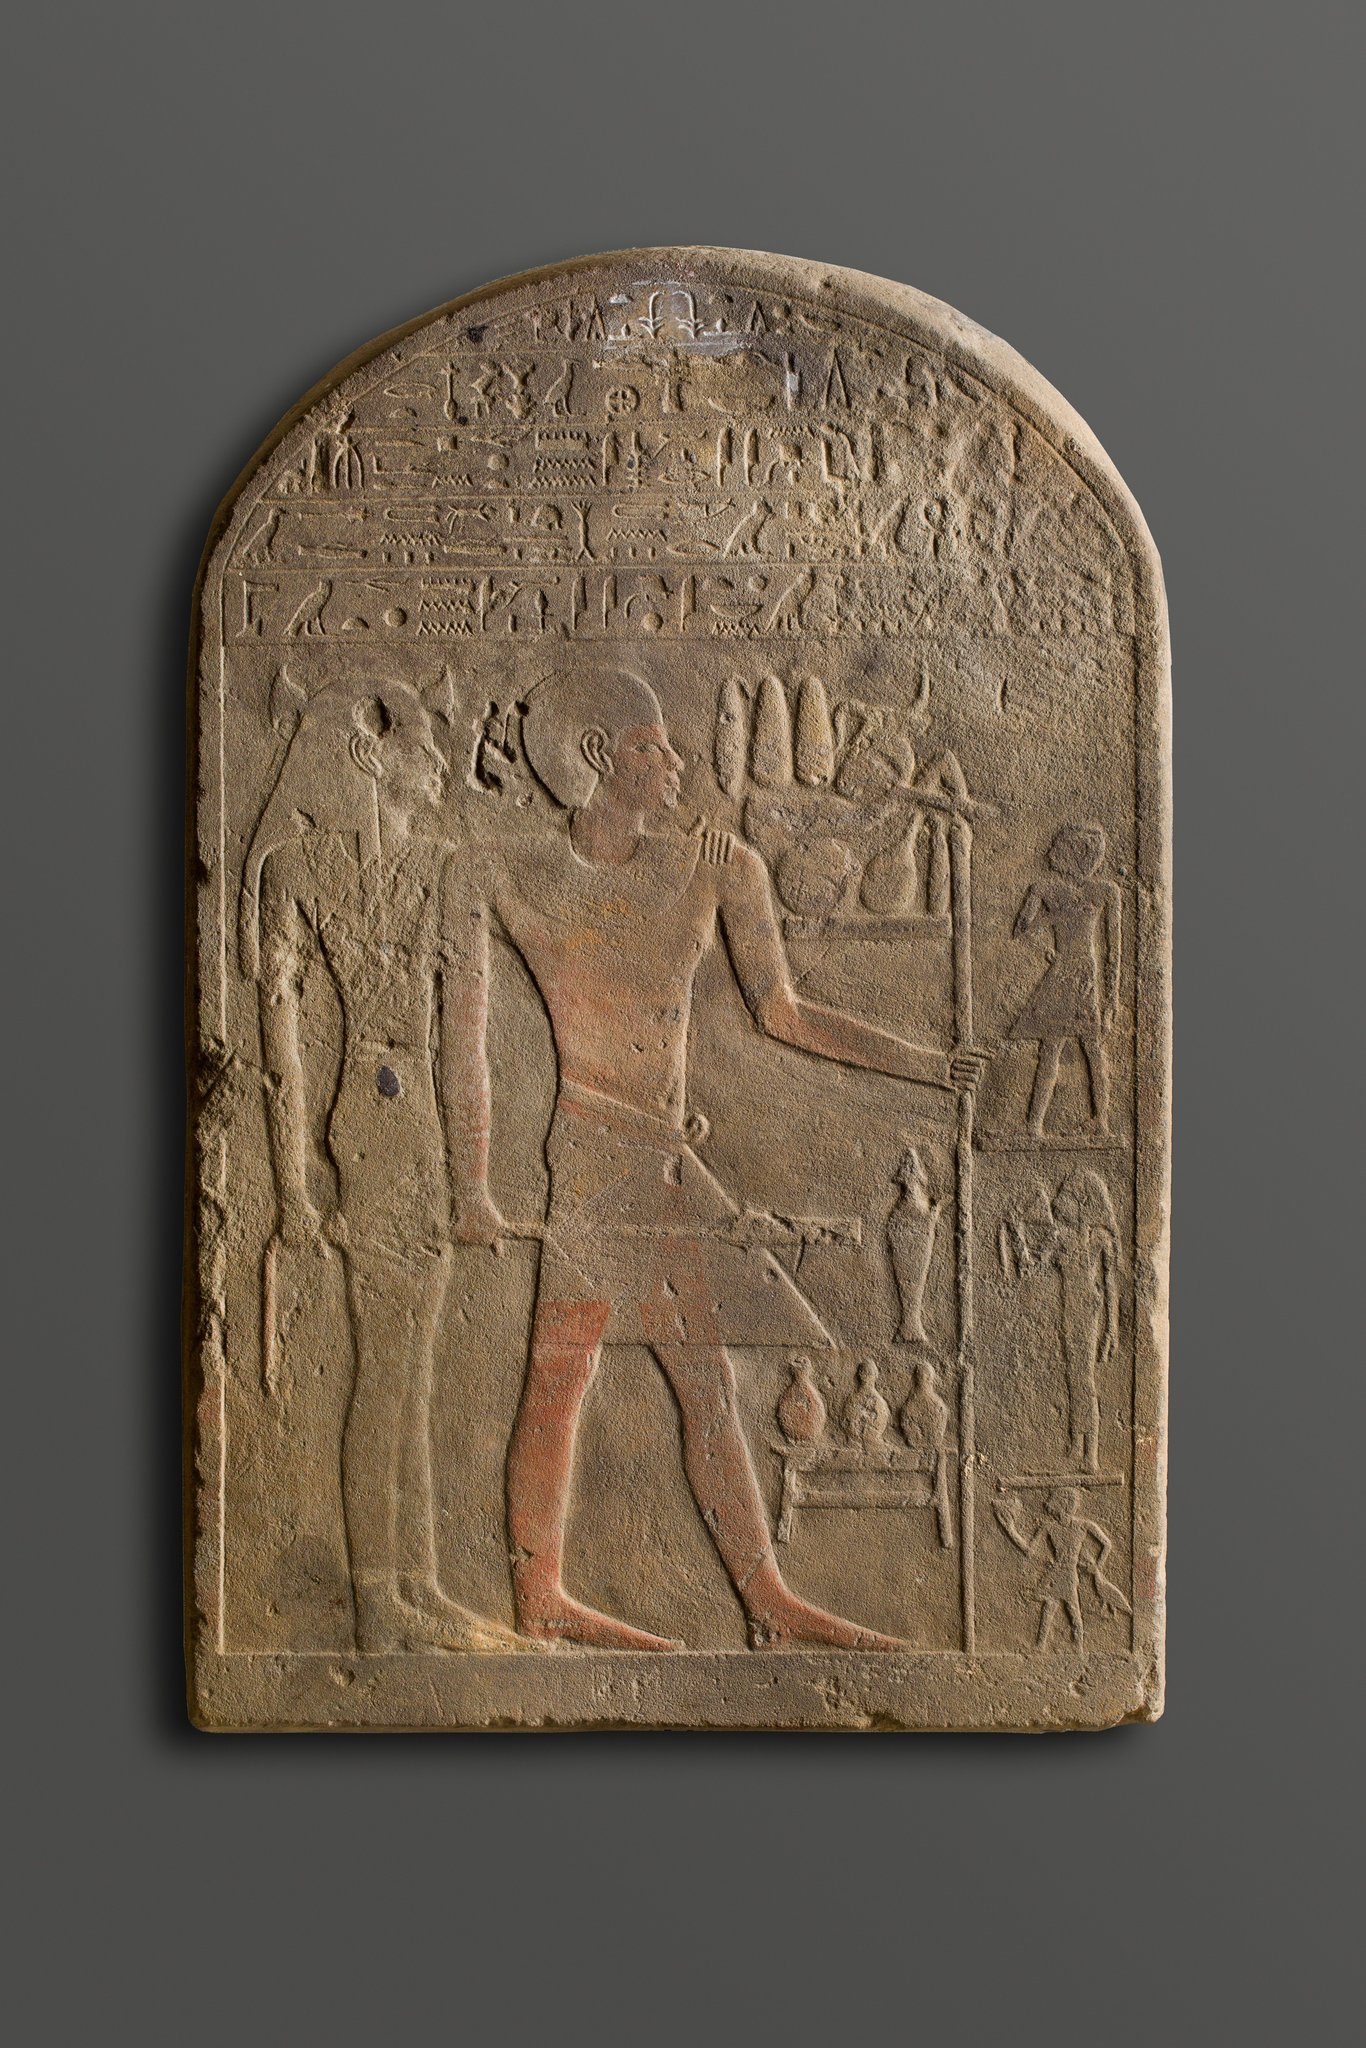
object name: stela, amennakht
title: Stela of Amennakht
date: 1981-1802 BCE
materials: paint, stone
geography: egypt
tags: men,women,hieroglyphs